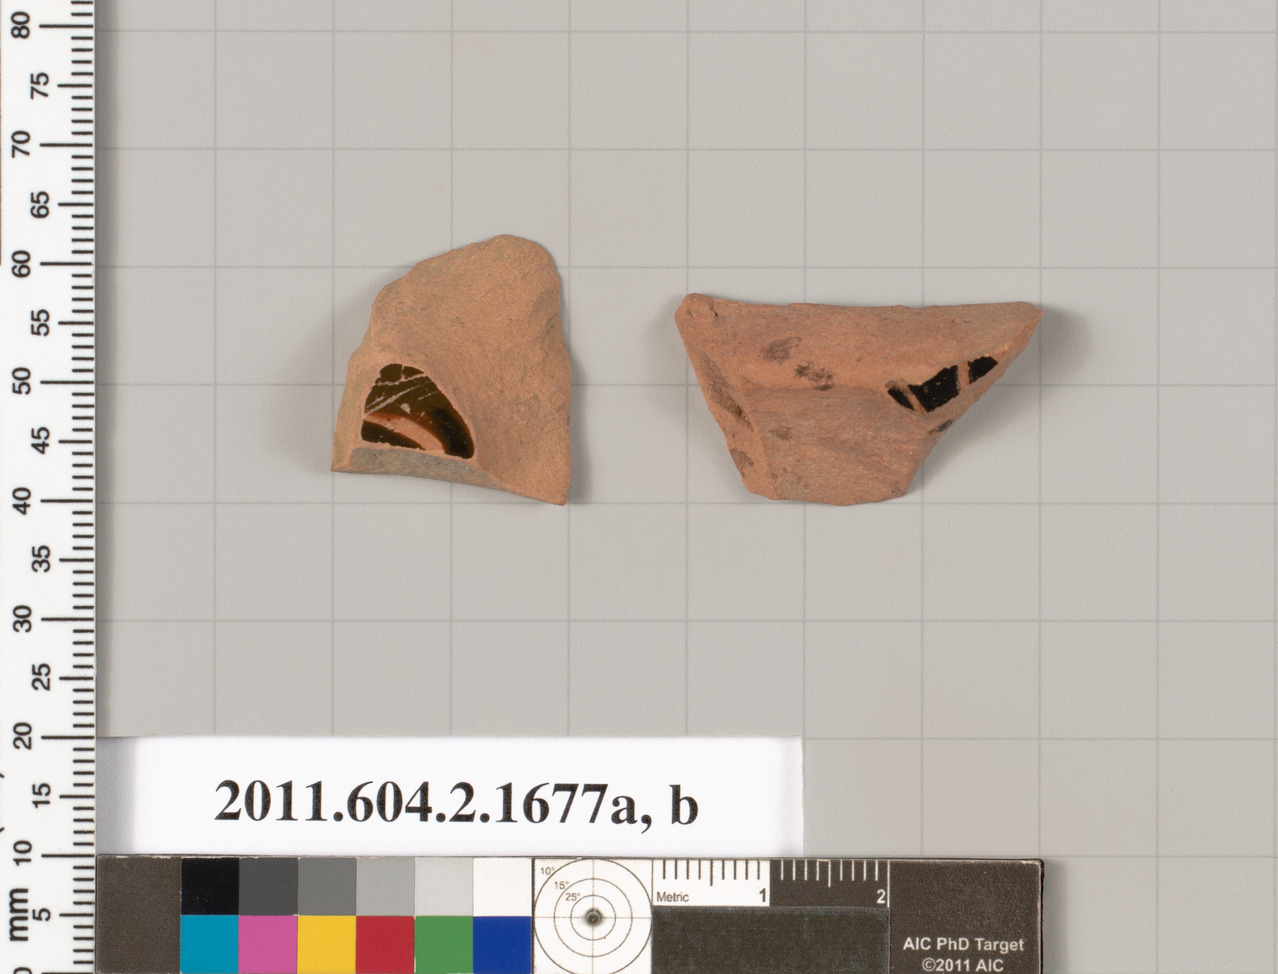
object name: skyphos fragment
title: Terracotta fragments of skyphoi (deep drinking cups)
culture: greek, attic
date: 450-401 BCE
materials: terracotta